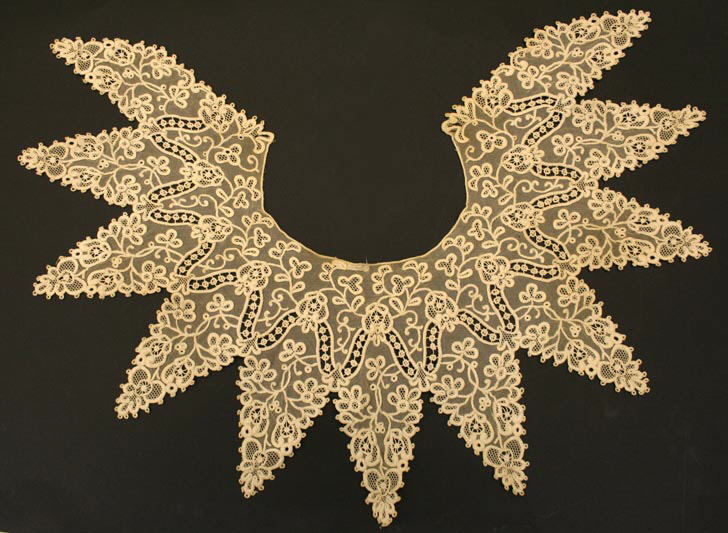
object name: collar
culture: american or european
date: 1700-1945